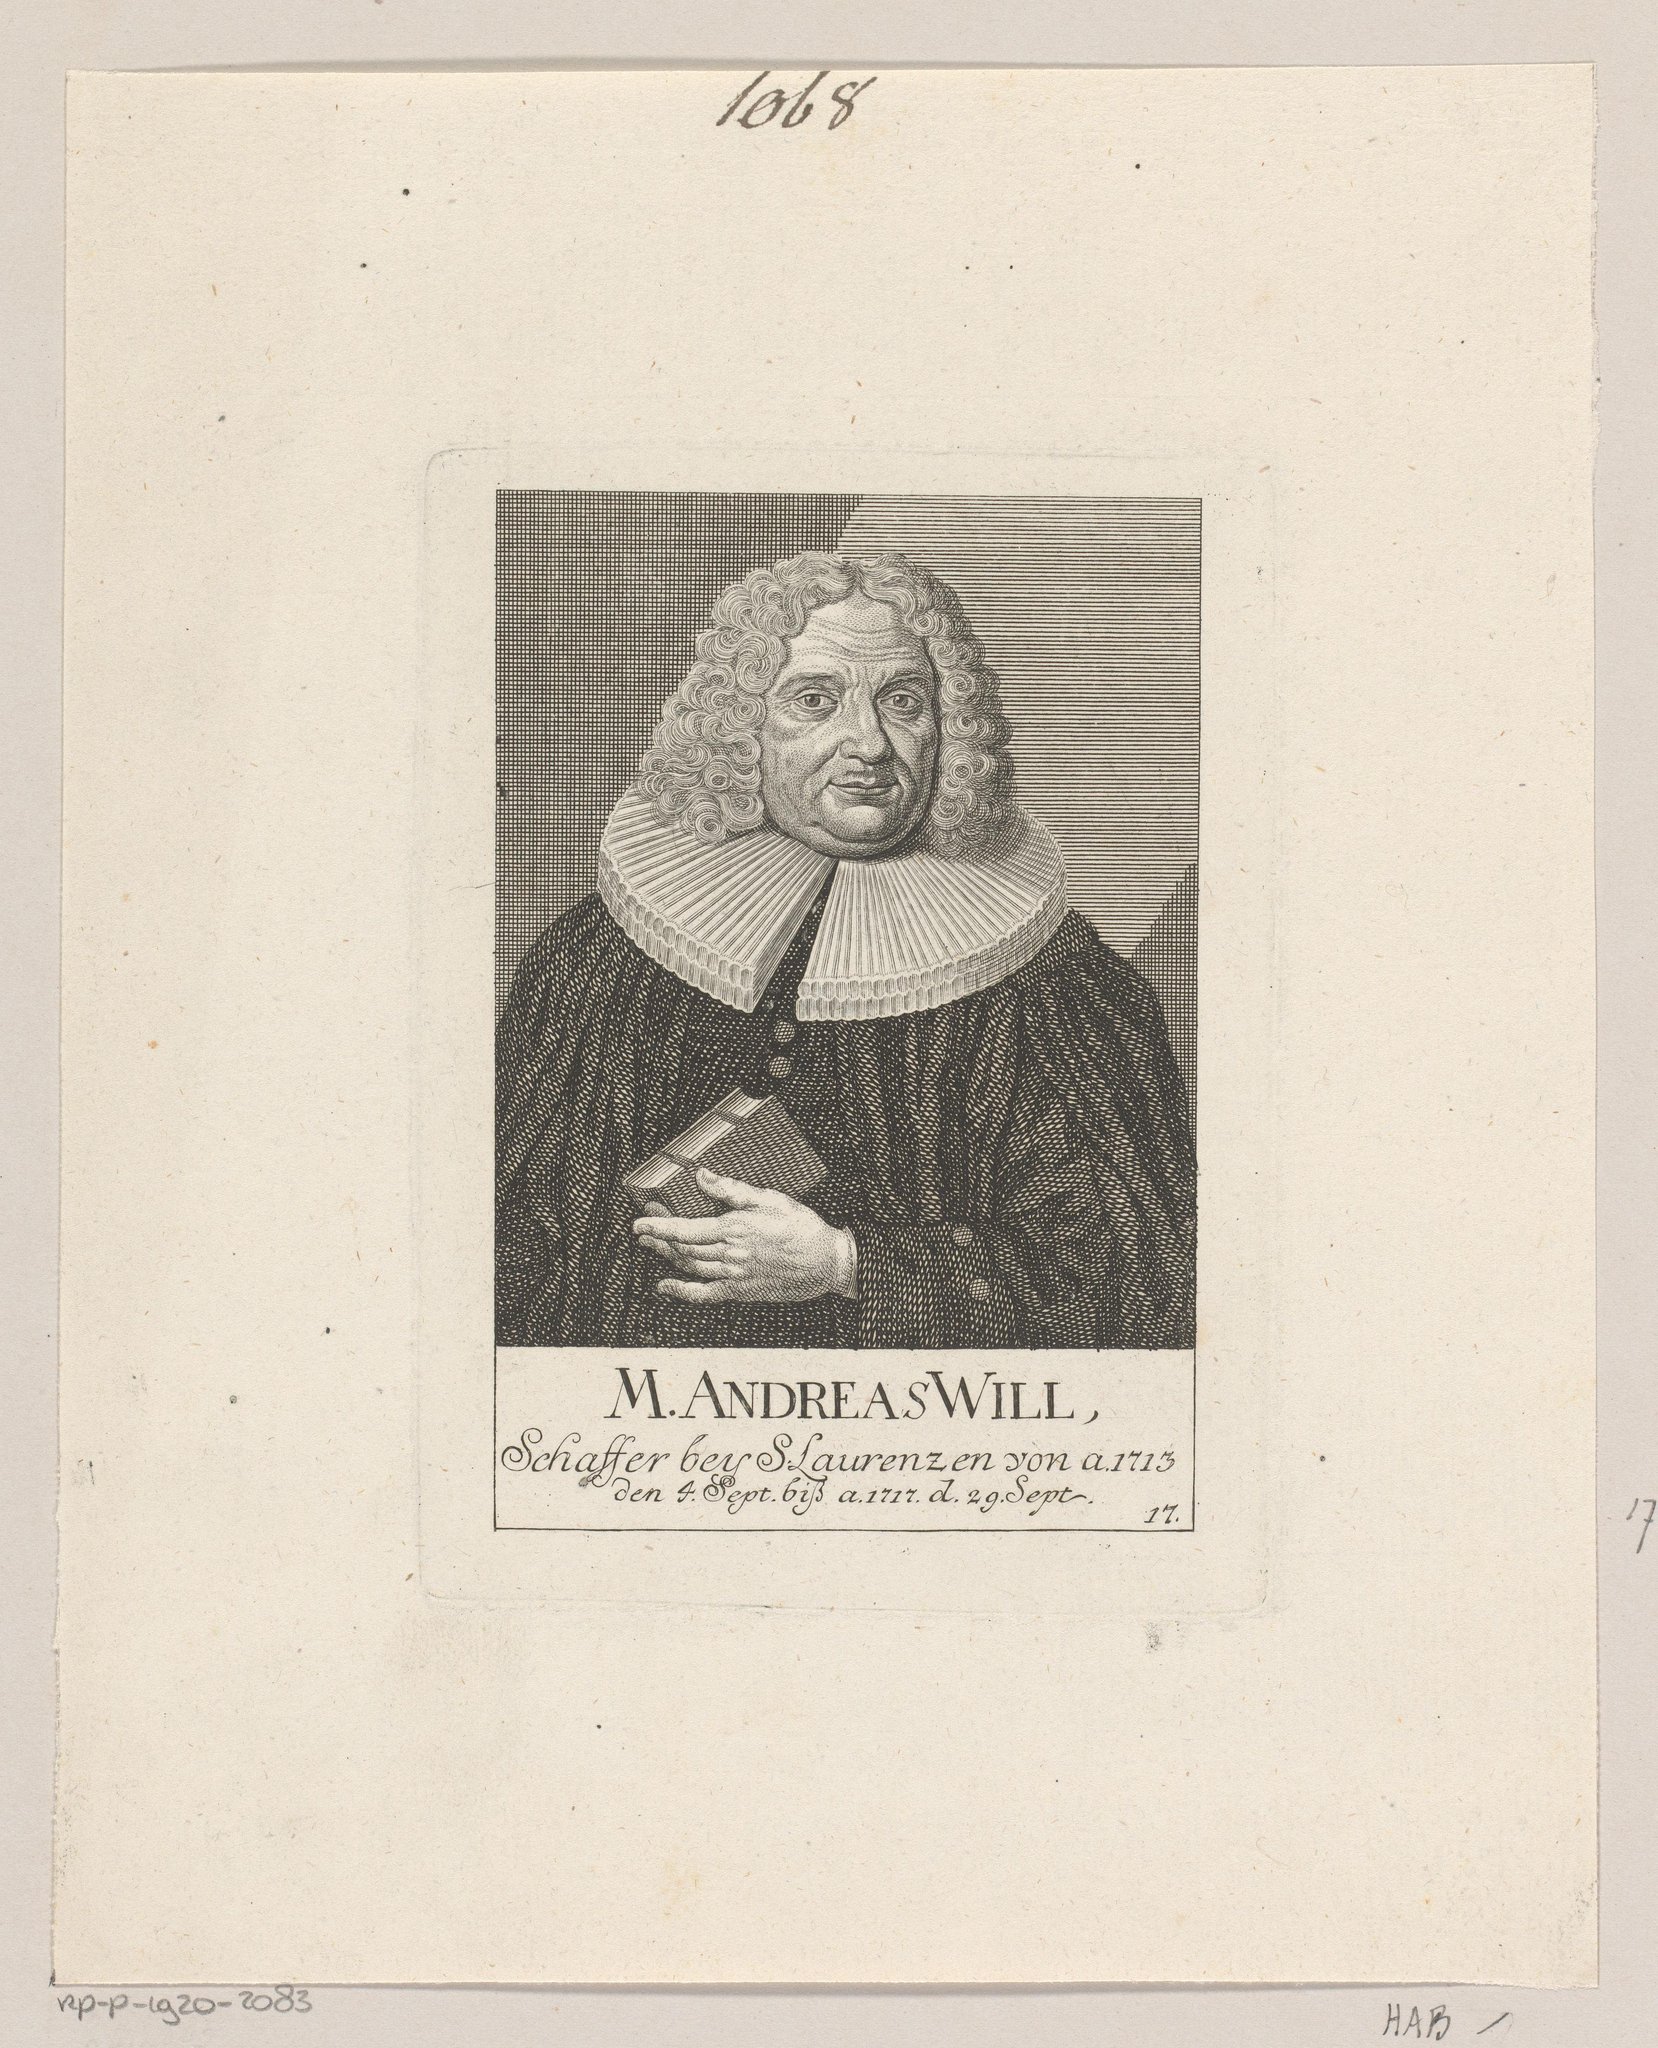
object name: book illustration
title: Portret van Andreas Will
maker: Anonymous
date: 1756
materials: paper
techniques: engraving, etching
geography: germany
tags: clergyman, theologian, historical persons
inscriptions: collector's mark: Lugt 2228, number: ‘1068’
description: Prent waarschijnlijk uit: Würfel, Andreas. Dipticha Ecclesiae Laurentianae (...). Neurenberg, Christoph Melchior Roth, 1756.